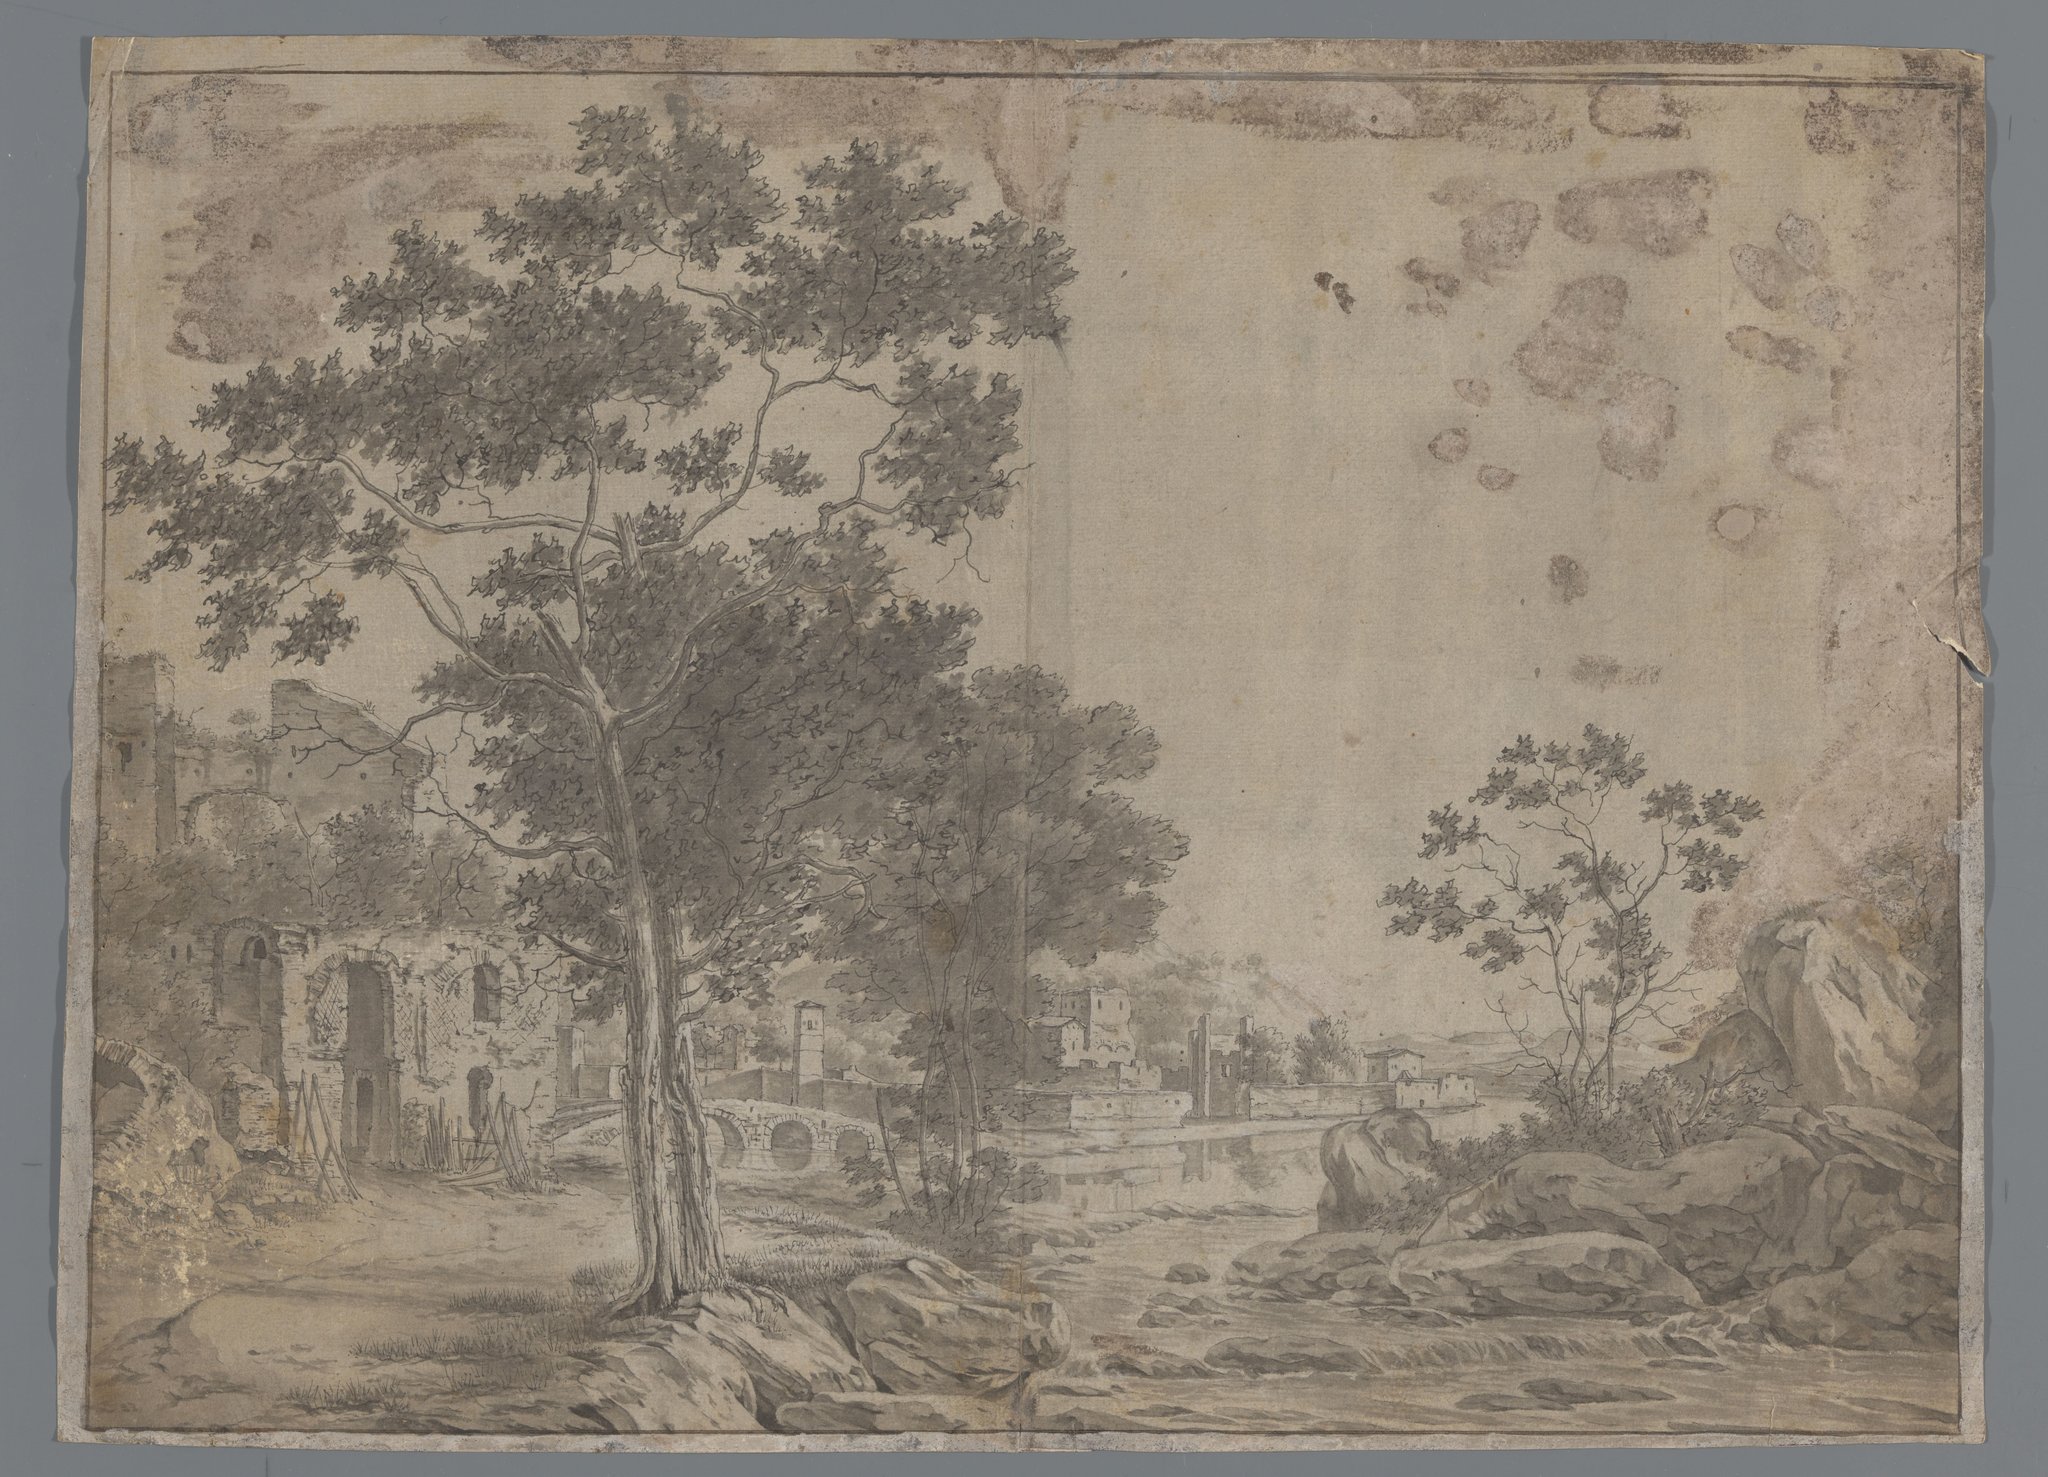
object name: drawing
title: Italiaans landschap met stenen brug, stadje en ruïne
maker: Anonymous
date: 1700-1800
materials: ink, paper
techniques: brush, pen